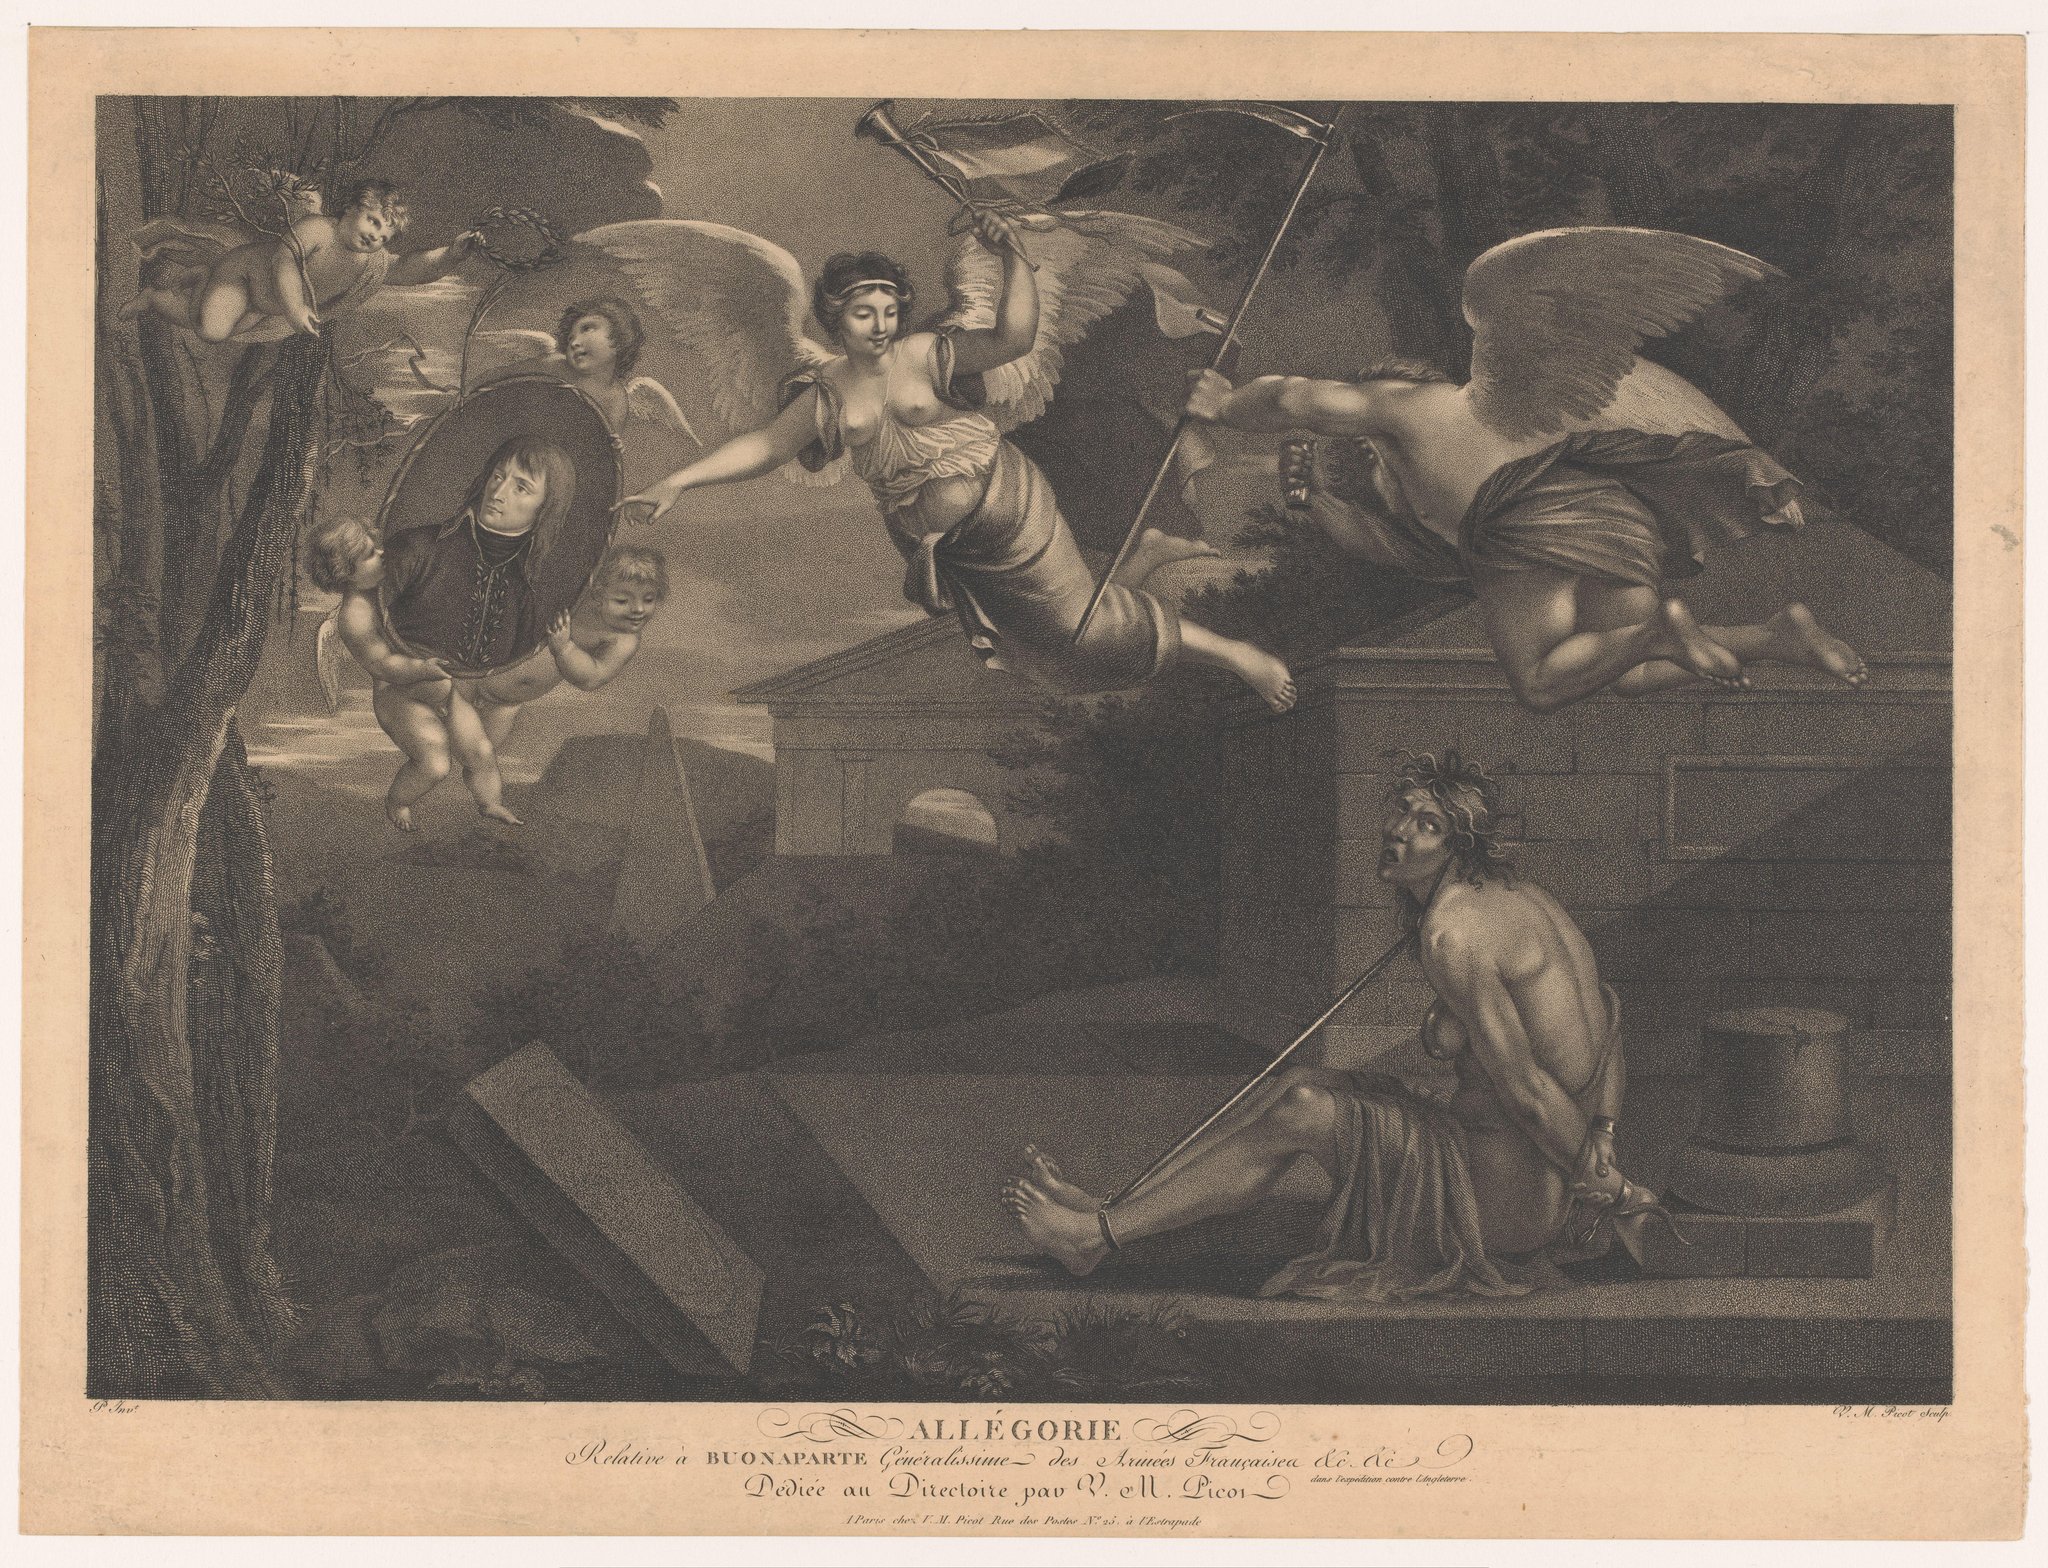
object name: print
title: Allégorie relative à Buonaparte Généralissime des Armées Francáisea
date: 1795-1802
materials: paper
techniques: engraving, etching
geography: paris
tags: napoleon i (emperor of the french), historical persons, fame; 'fama', 'fama buona', 'fama chiara' (ripa), father time, man with wings and scythe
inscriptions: collector's mark: Lugt 2228, collector's mark: Lugt 2760